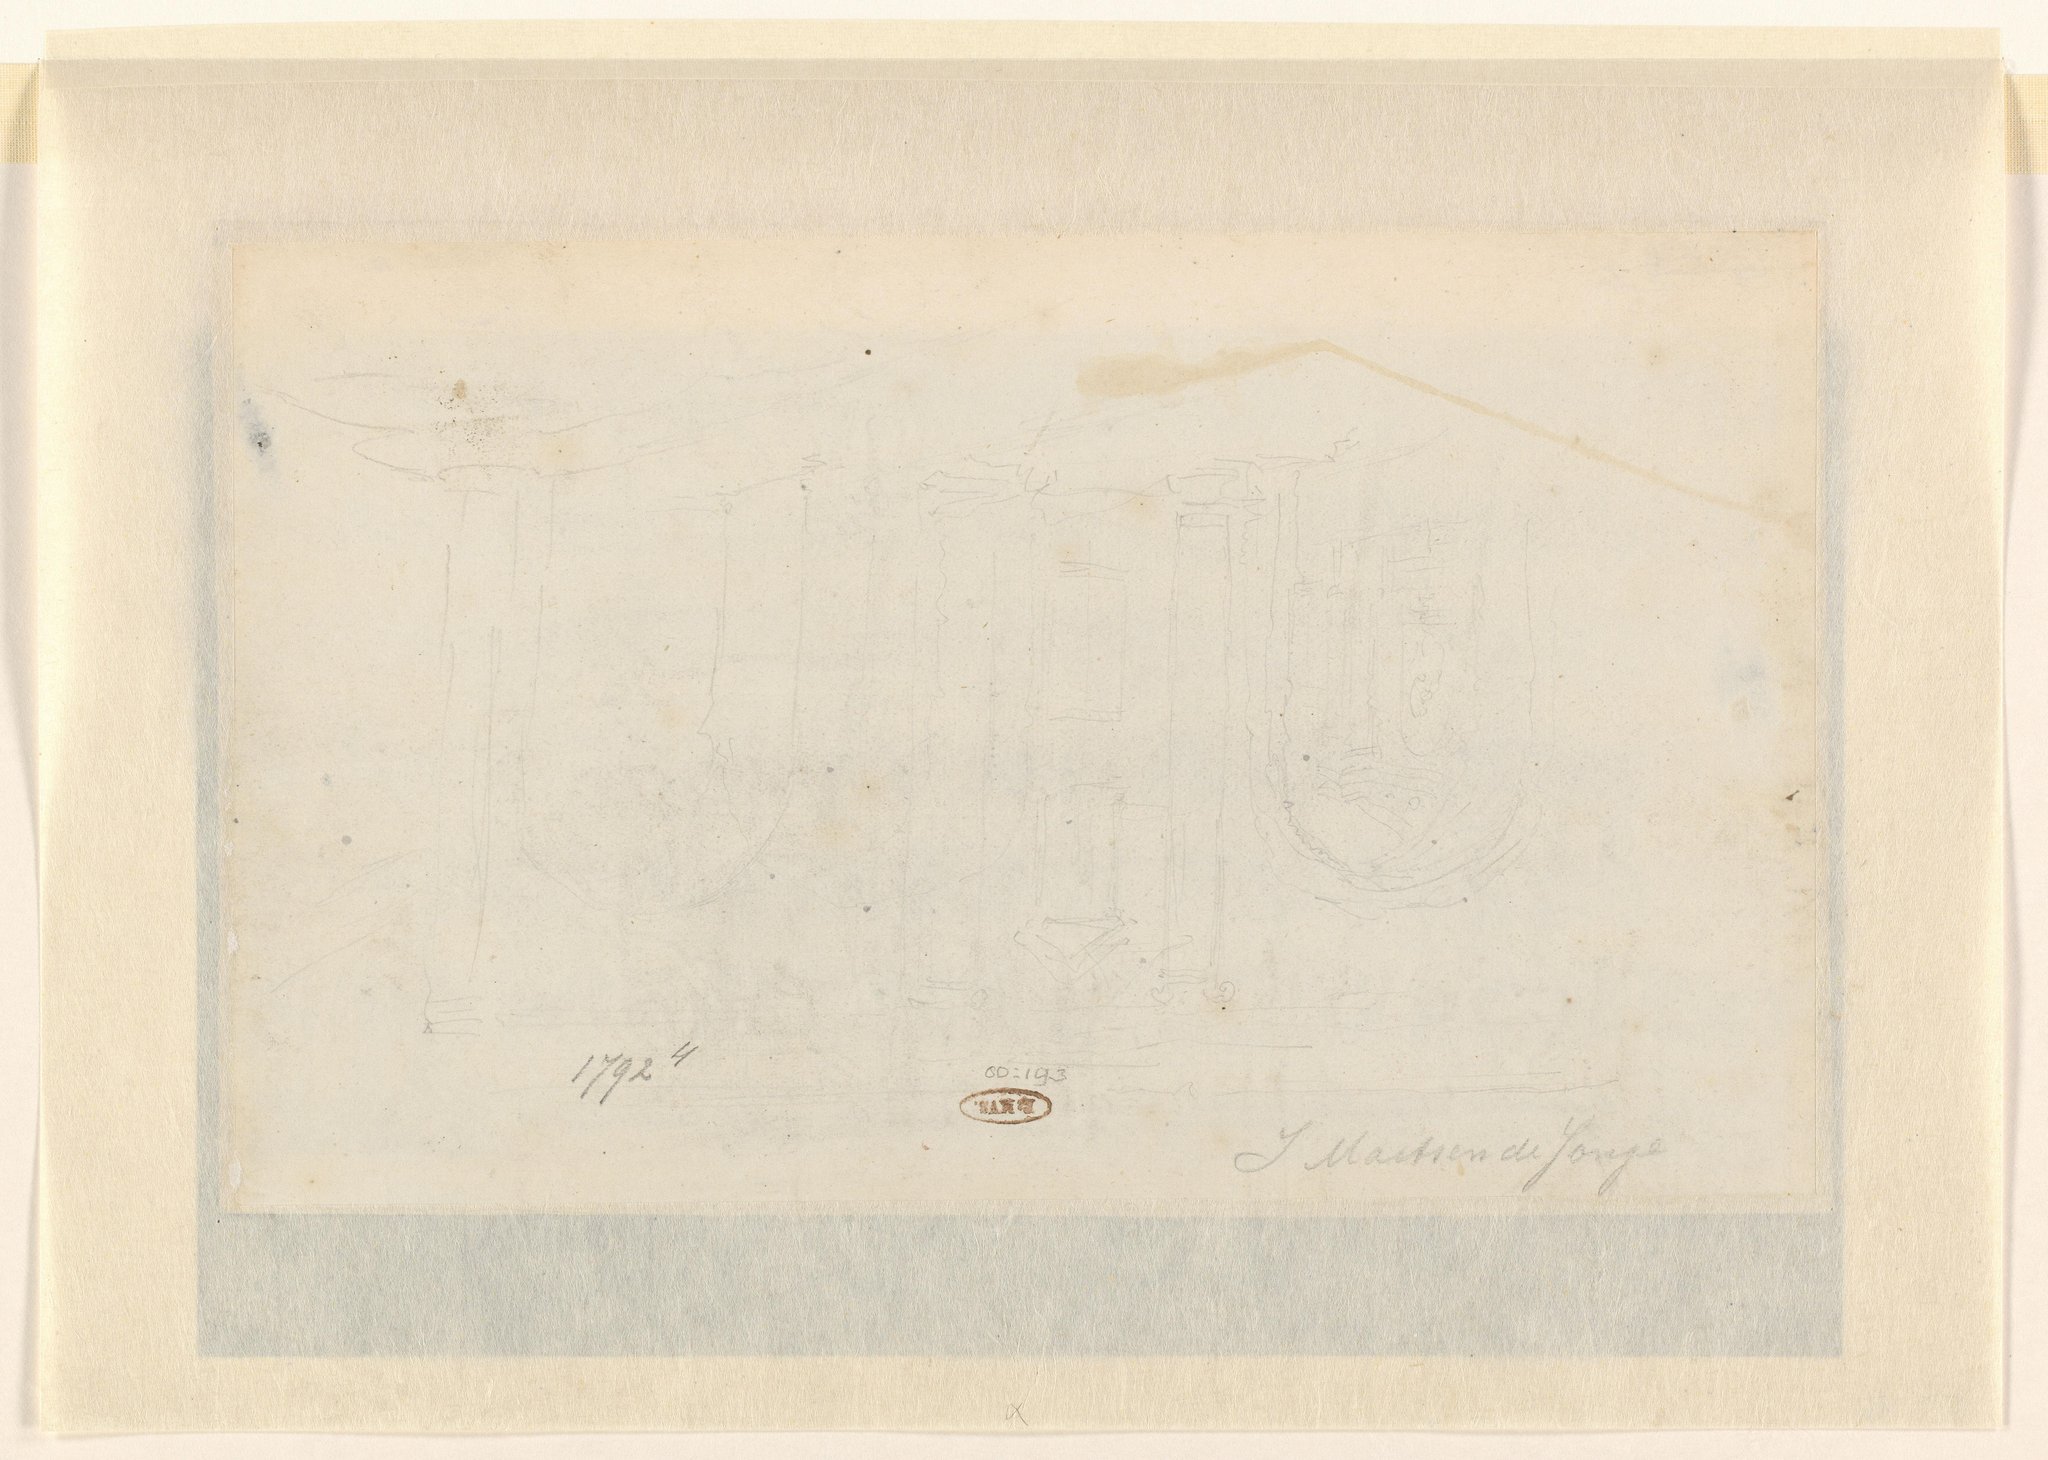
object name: design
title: Architectuurontwerp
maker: jan martszen de jonge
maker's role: draughtsman, painter, print maker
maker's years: 1609-1647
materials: chalk, paper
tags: land forces (+ cavalry, horsemen), triumphal entry and public reception, pageant, 'entrée solennelle', 'joyeuse entrée', military celebrations, historical events and situations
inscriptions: annotation: ‘1792 4; merk RPK (L.2228); daarnaast: J. Martsen de Jonge’